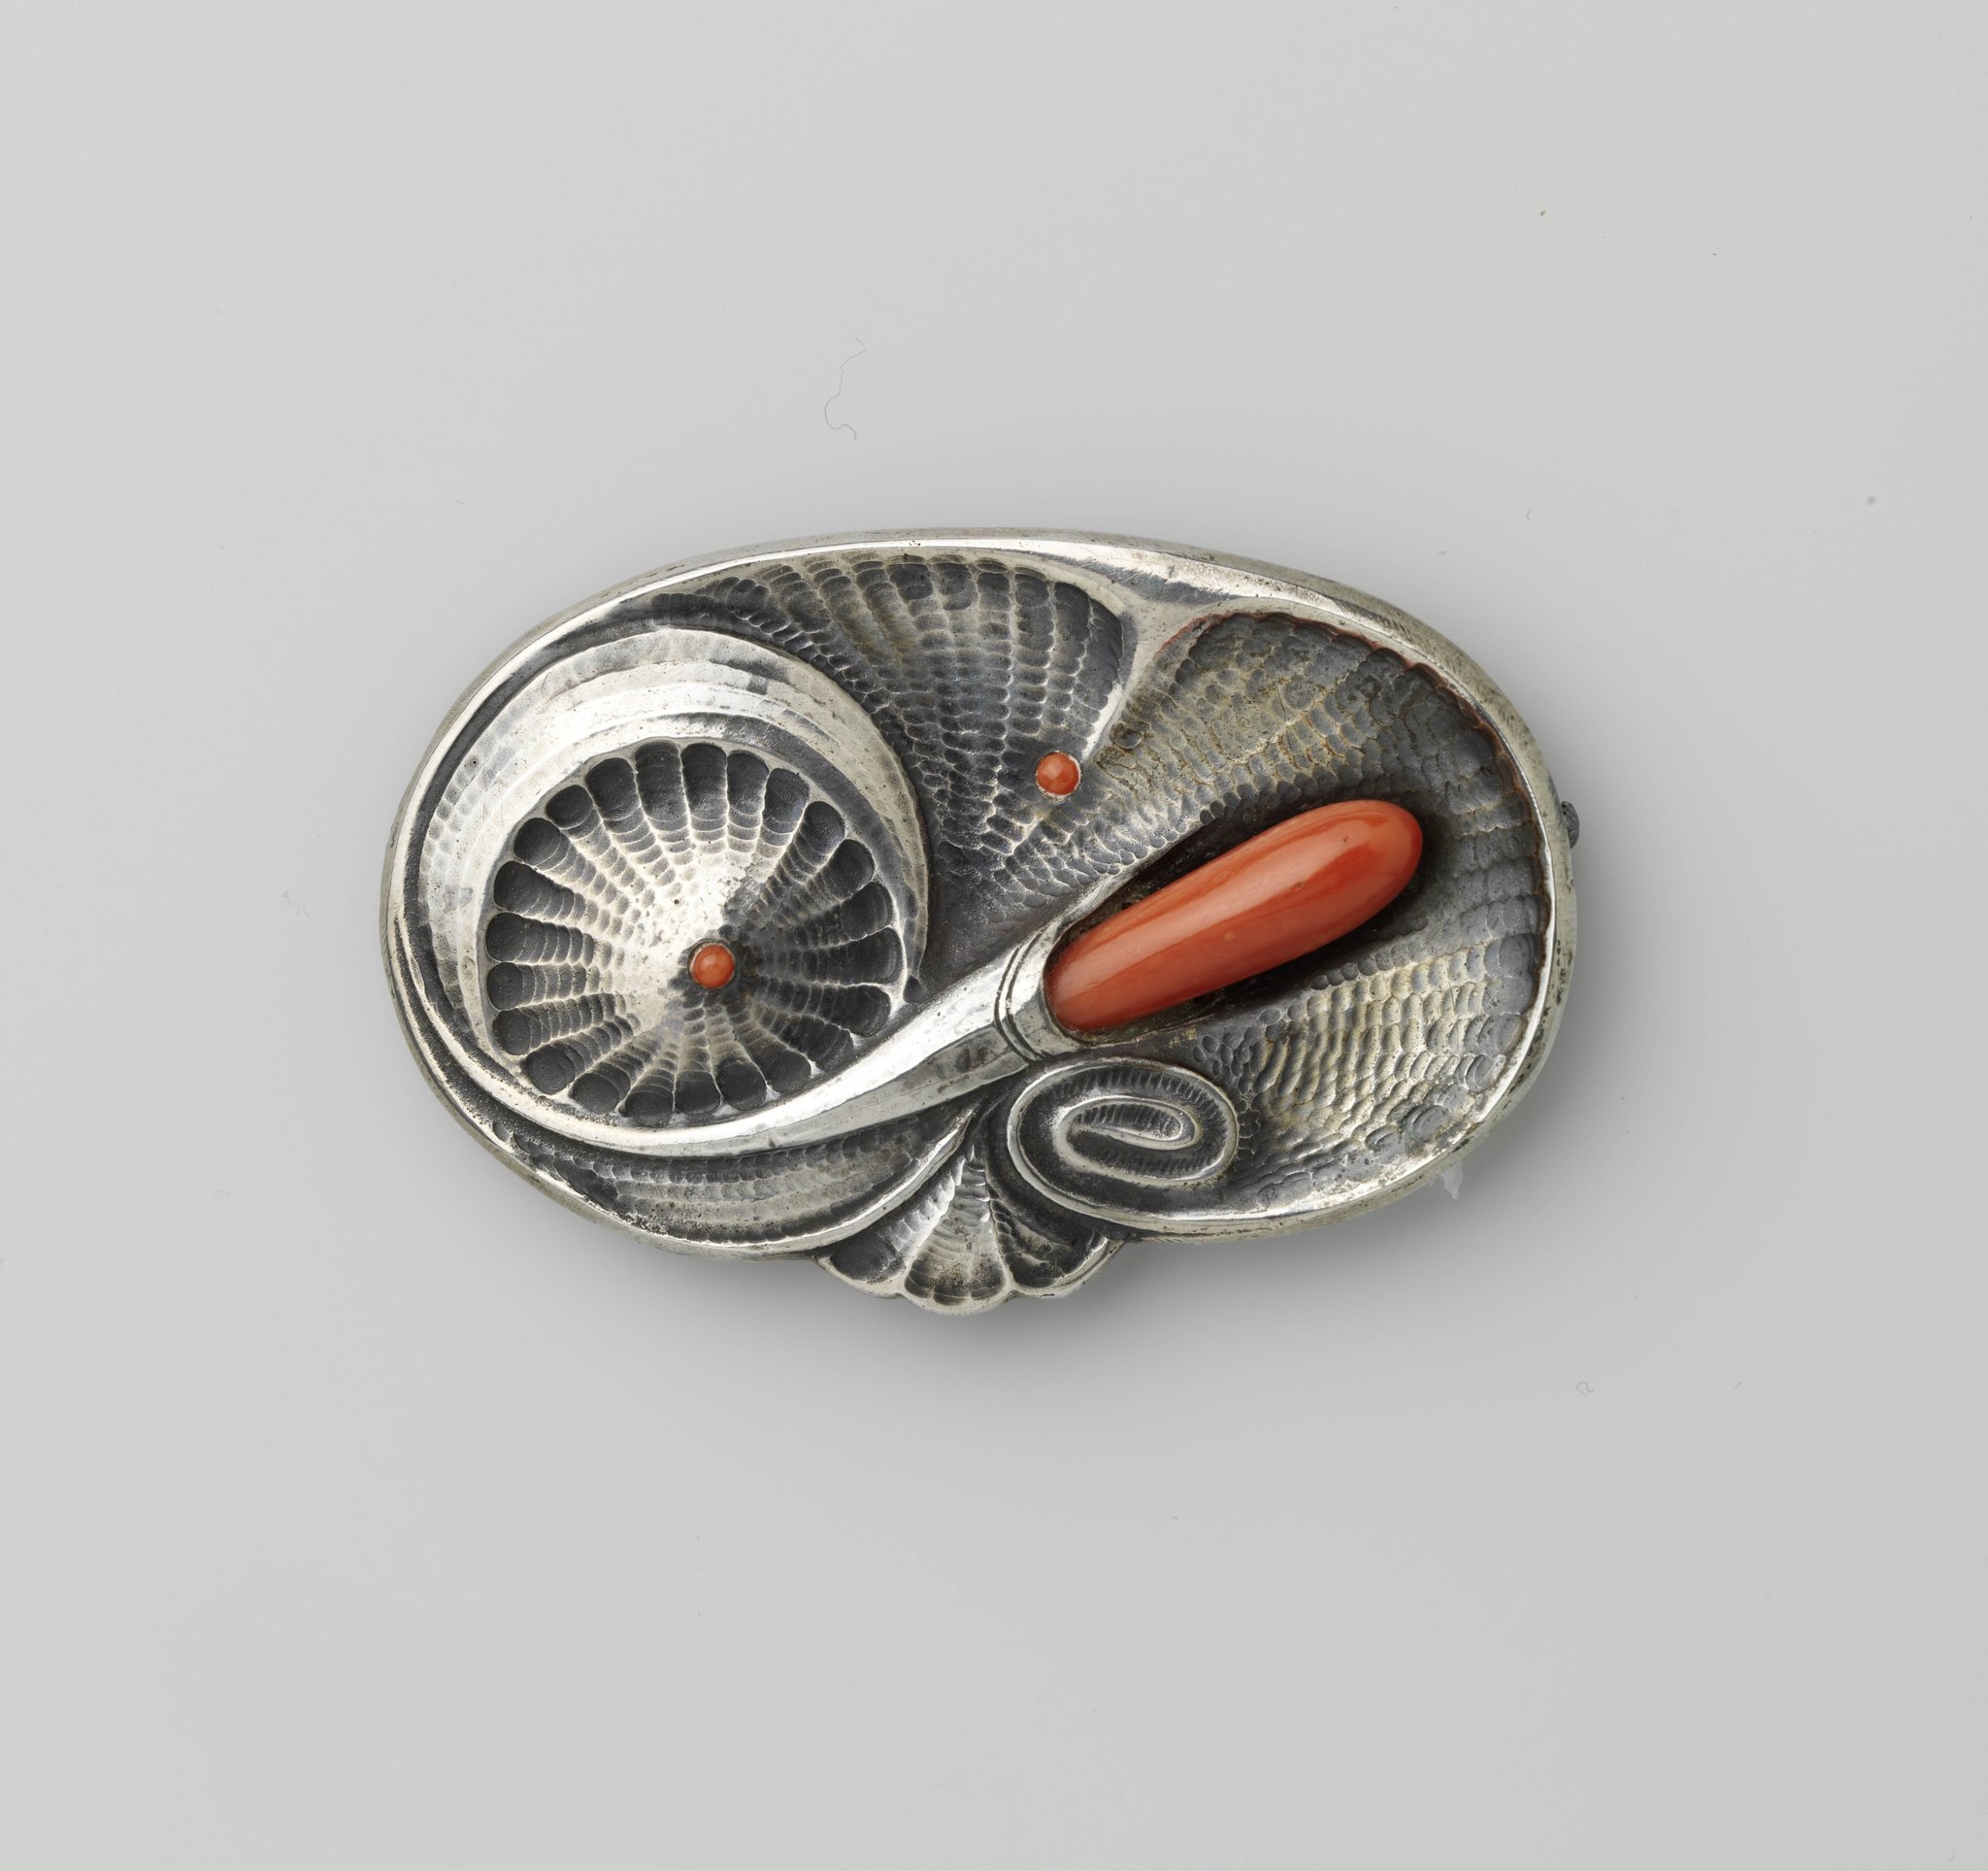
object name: jewellery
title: Broche van zilver en bloedkoraal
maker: fons reggers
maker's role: jeweler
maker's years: 1886-1962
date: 1925-1935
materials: coral, silver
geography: amsterdam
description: In de vorm van een gestileerd plantaardig motief versierd met twee kleine ronde koralen en 1 pegelvormige.